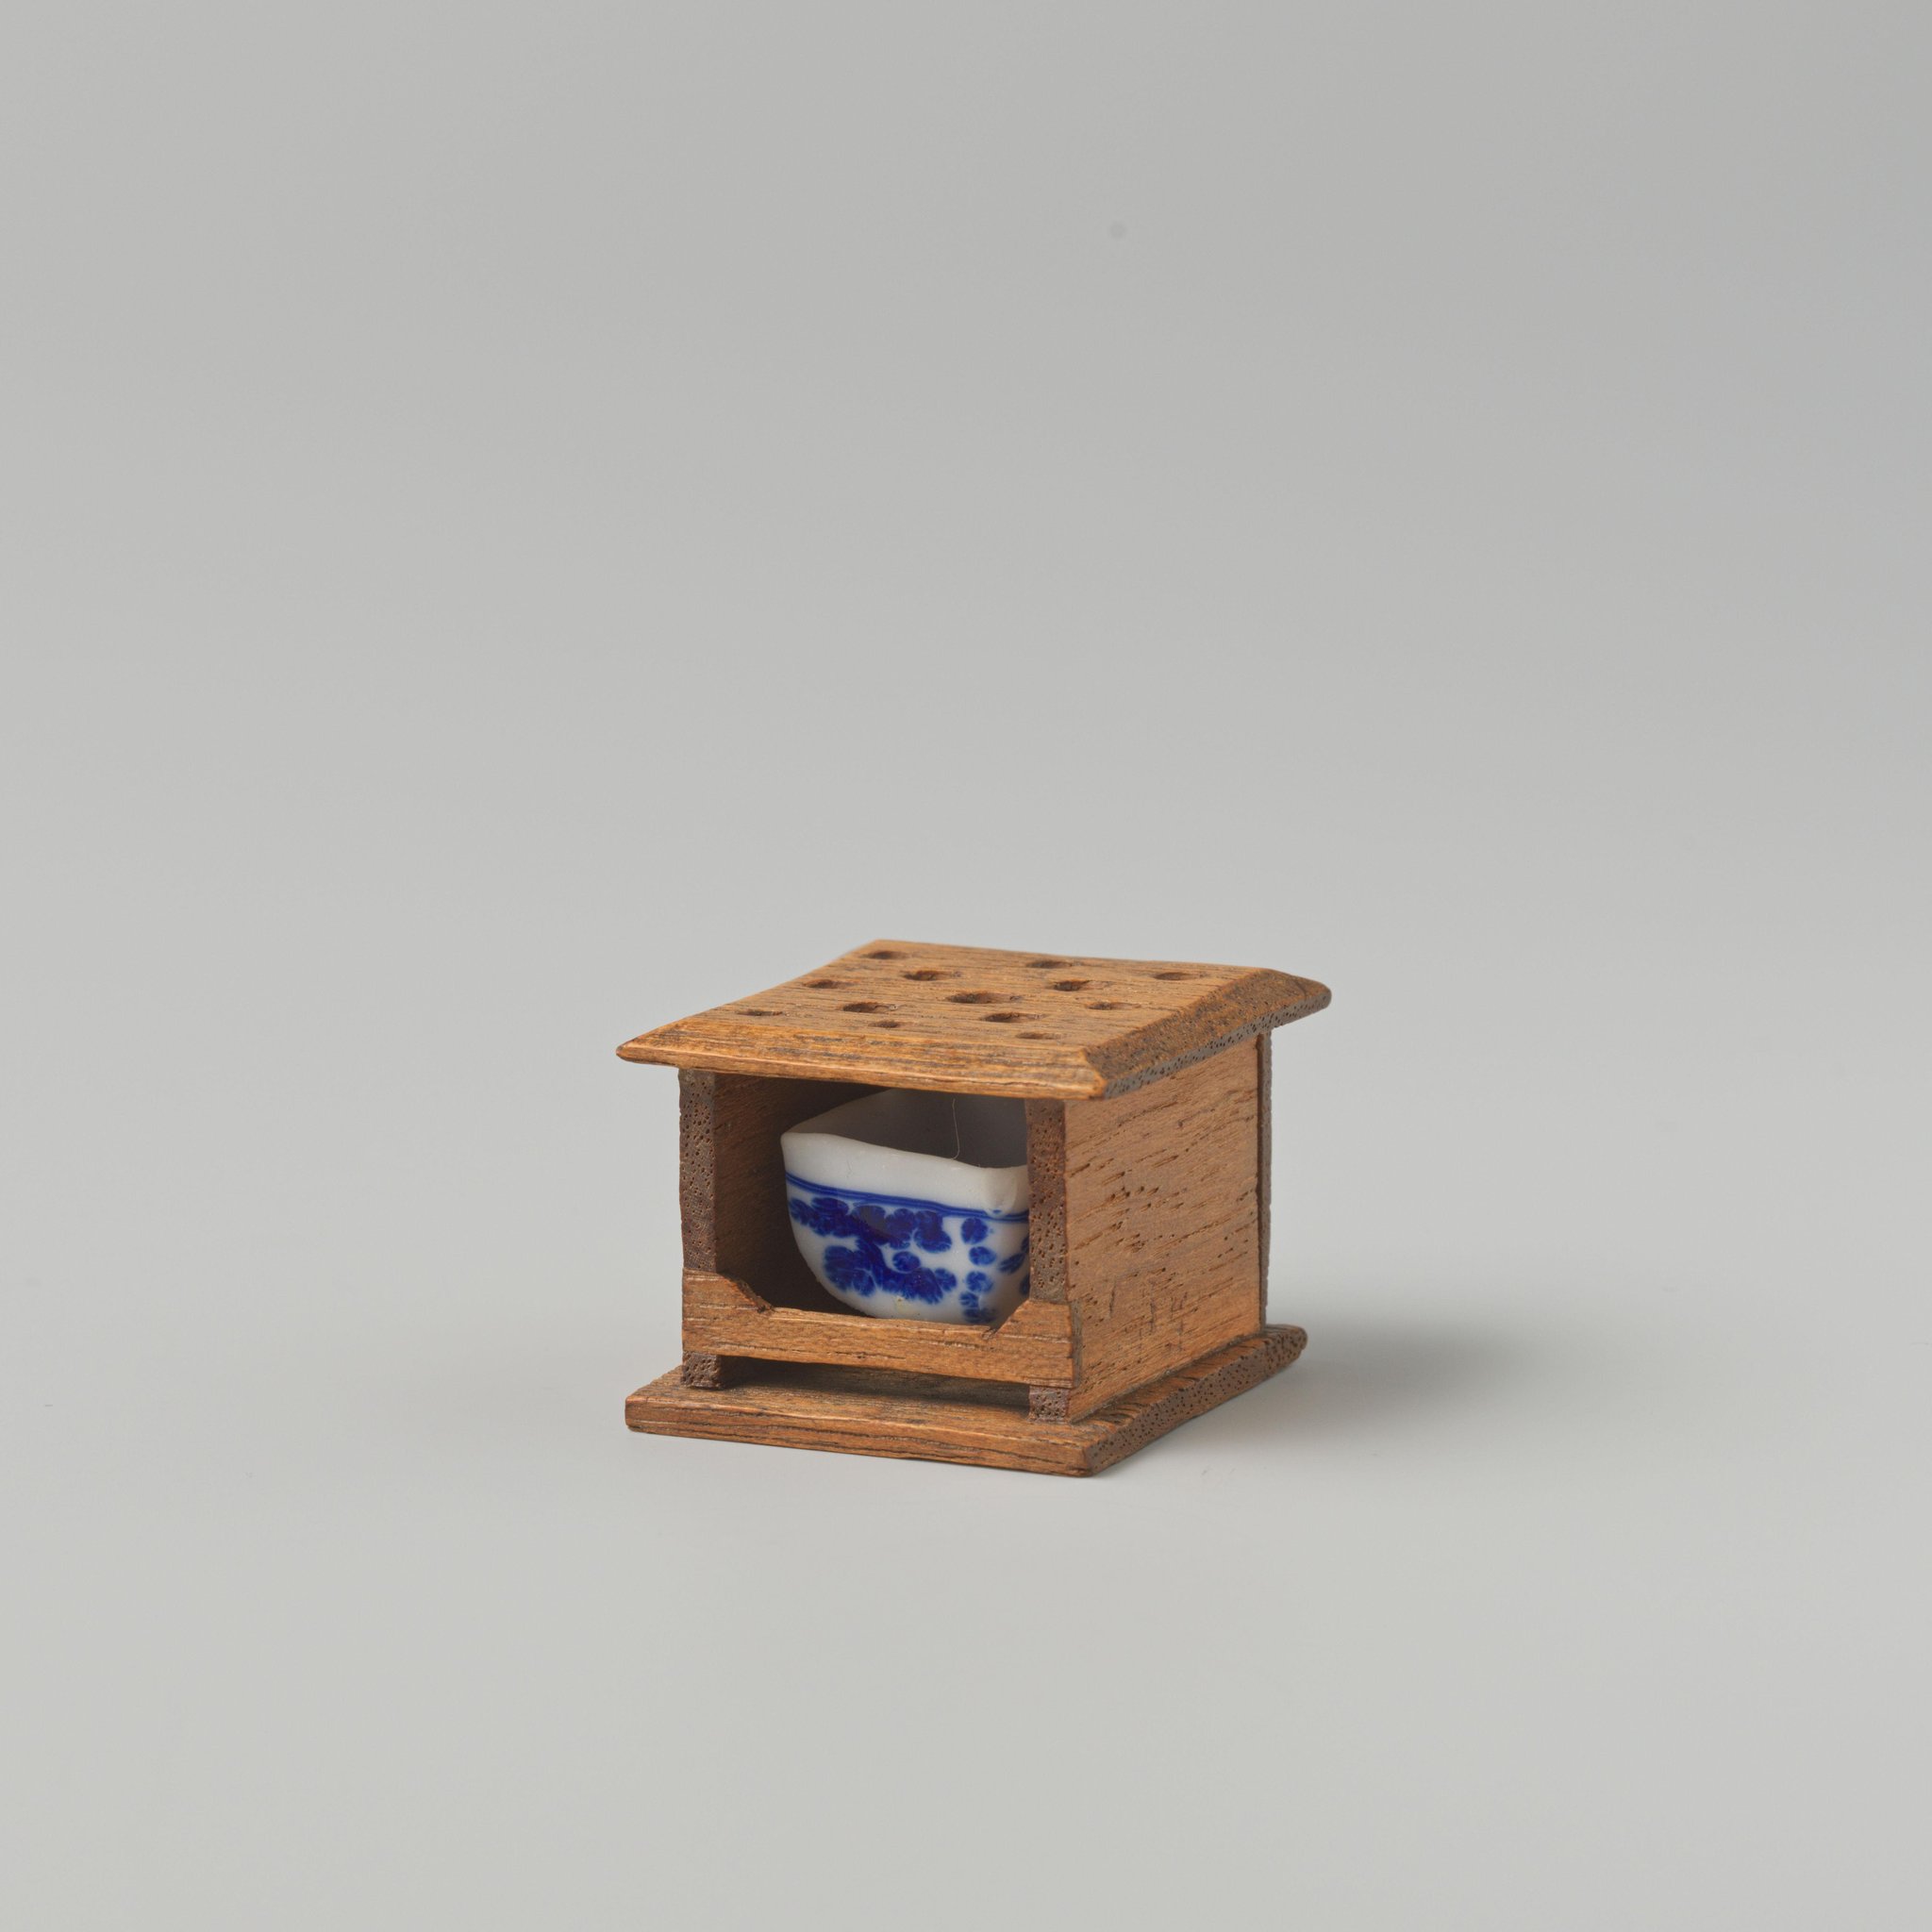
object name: voetstoof, stoof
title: Vierkant stoof van cederhout (?); de voetenplank is doorboord met 13 gaten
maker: Anonymous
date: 1690-1710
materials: wood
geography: amsterdam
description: Vierkante stoof van cederhout; de voetenplank is doorboord met dertien gaten.